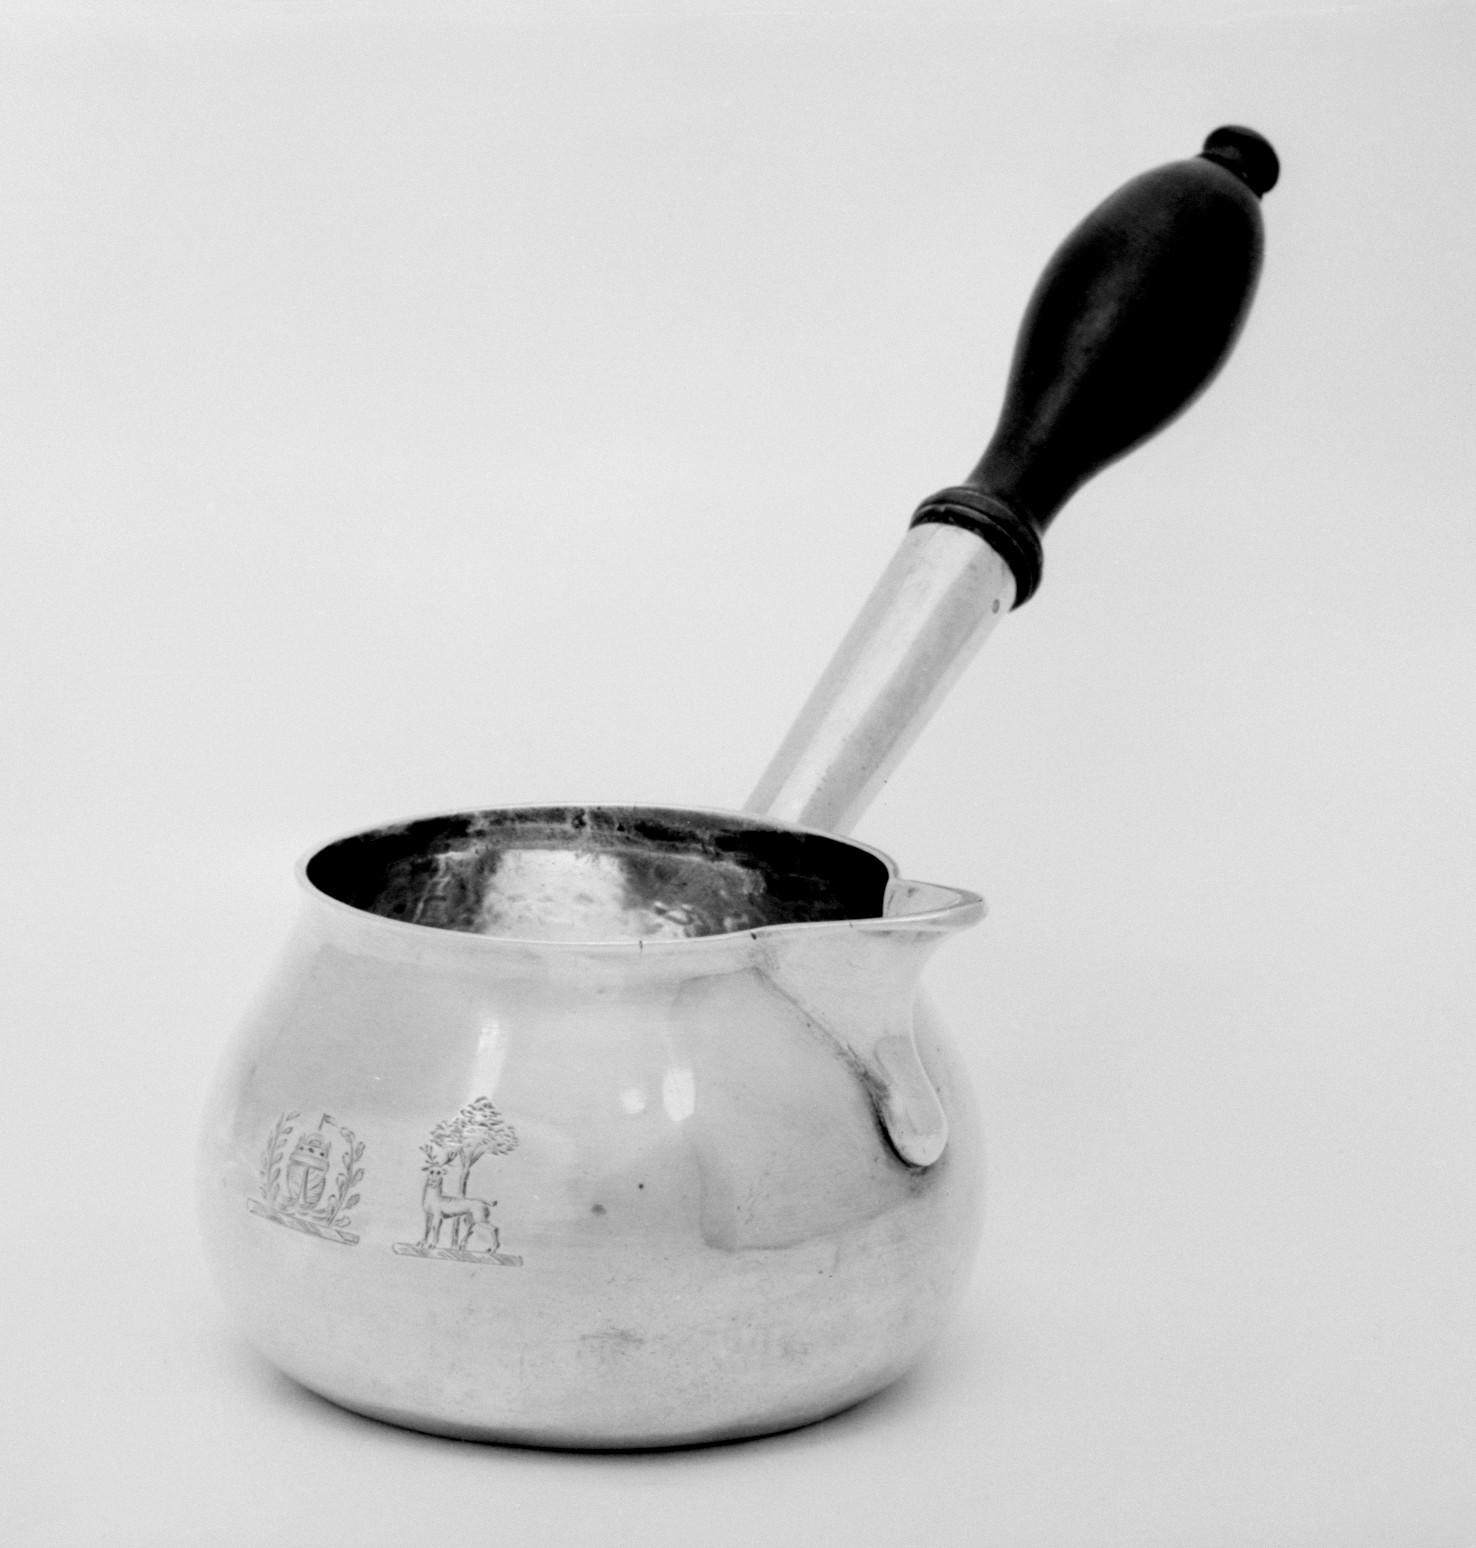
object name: toddy warmer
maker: george jones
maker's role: maker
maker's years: 1724-1744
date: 1738-1739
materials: silver, wood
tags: coat of arms